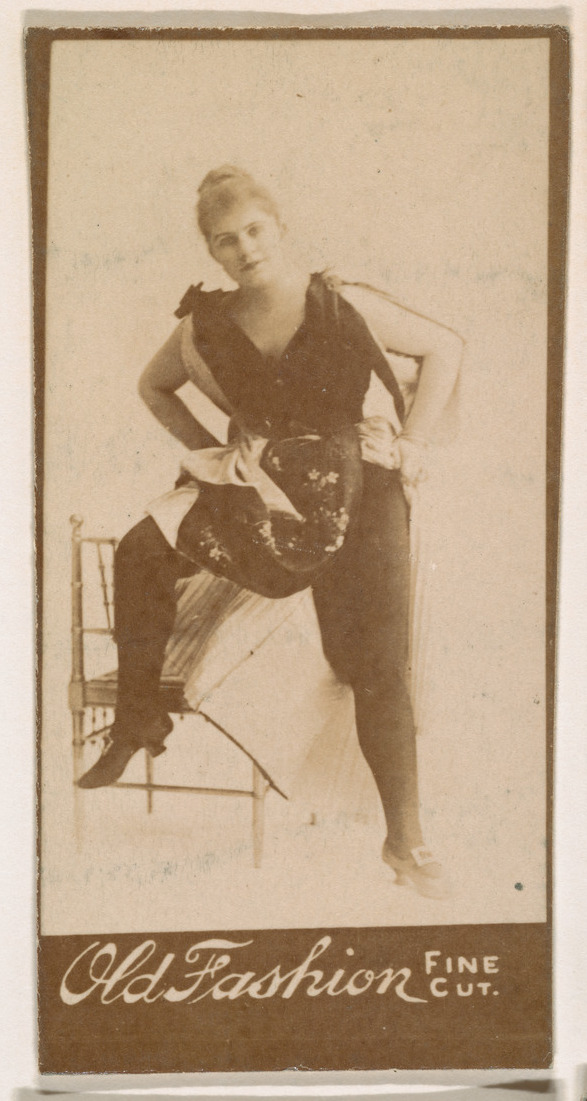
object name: photograph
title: Actress posing with foot on chair, from the Actresses series (N664) promoting Old Fashion Fine Cut Tobacco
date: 1888-1890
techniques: albumen silver print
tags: portraits,women,actresses